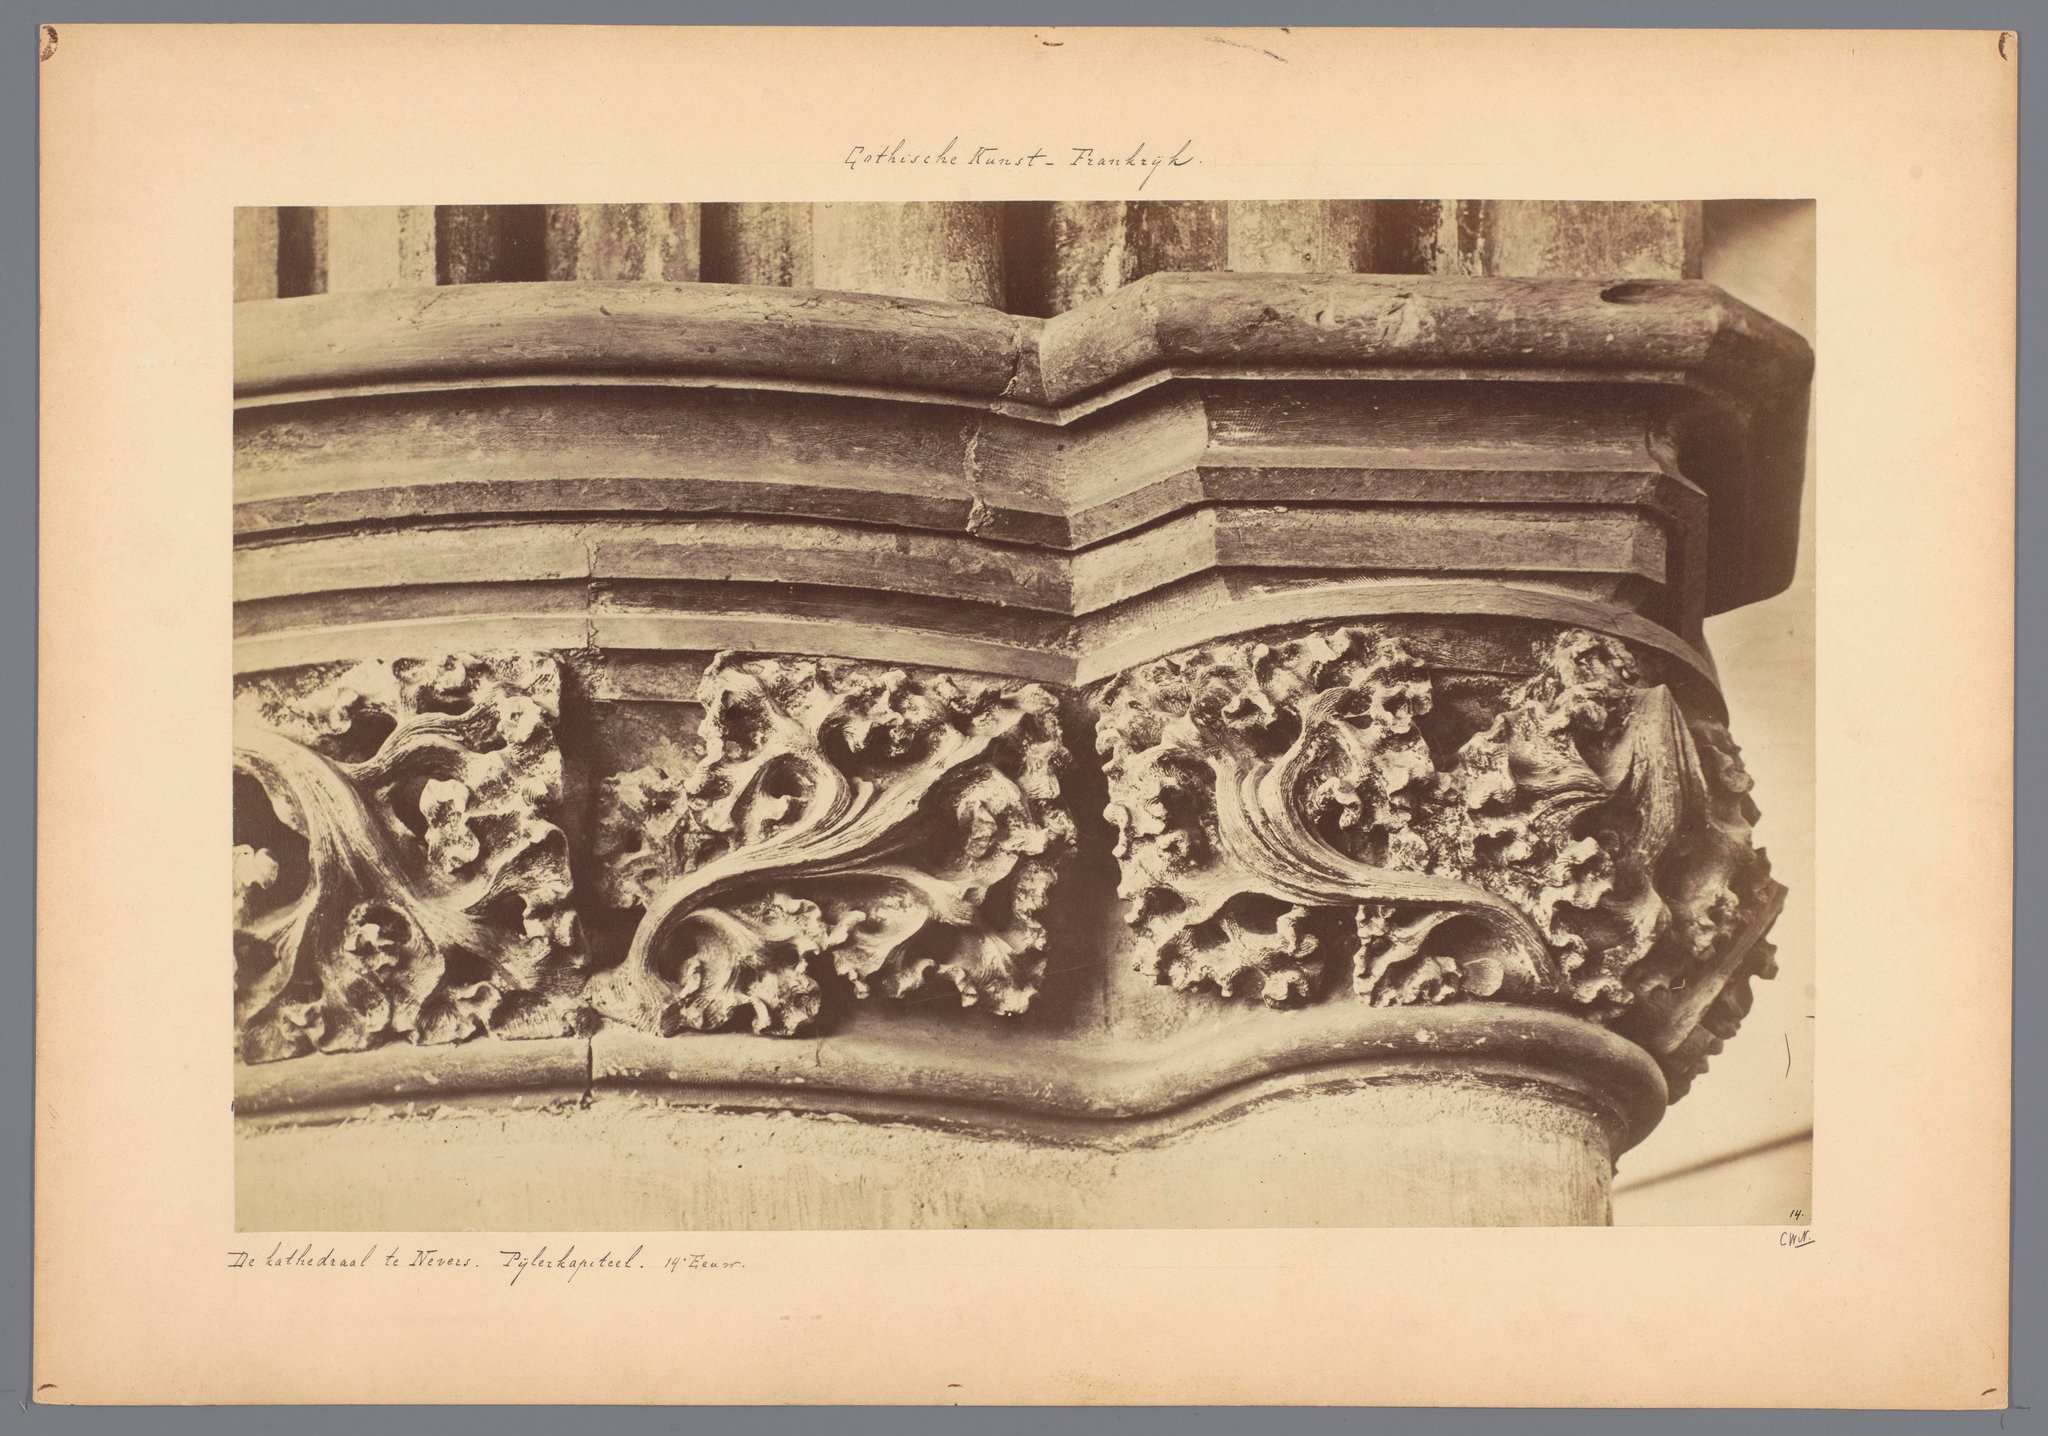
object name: photograph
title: De Kathedraal te Nevers. Pijlerkapiteel.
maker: séraphin-médéric mieusement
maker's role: fotograaf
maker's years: 1840-1905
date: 1875-1900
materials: cardboard, photographic support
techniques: albumen print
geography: nevers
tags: foliage, tendrils, branches ~ ornament - aa - stylized, capital (~ column, pillar)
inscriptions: number: ‘14’, collector's mark: ‘KUNSTNIJVERHEIDSCHOOL QUELLINUS AMSTERDAM FRANS HALSSTRAAT 14.’, inscription: ‘MONUMENTS HISTORIQUES’, inscription: ‘Gothische Kunst - Frankrijk.’, inscription: ‘CWN.’, name: ‘MIEUSEMENT’, collector's mark: ‘INSTITUUT VOOR KUNST-NIJVERHEIDSONDERWIJS GABRIËL METSUSTRAAT No. 16 AMSTERDAM’